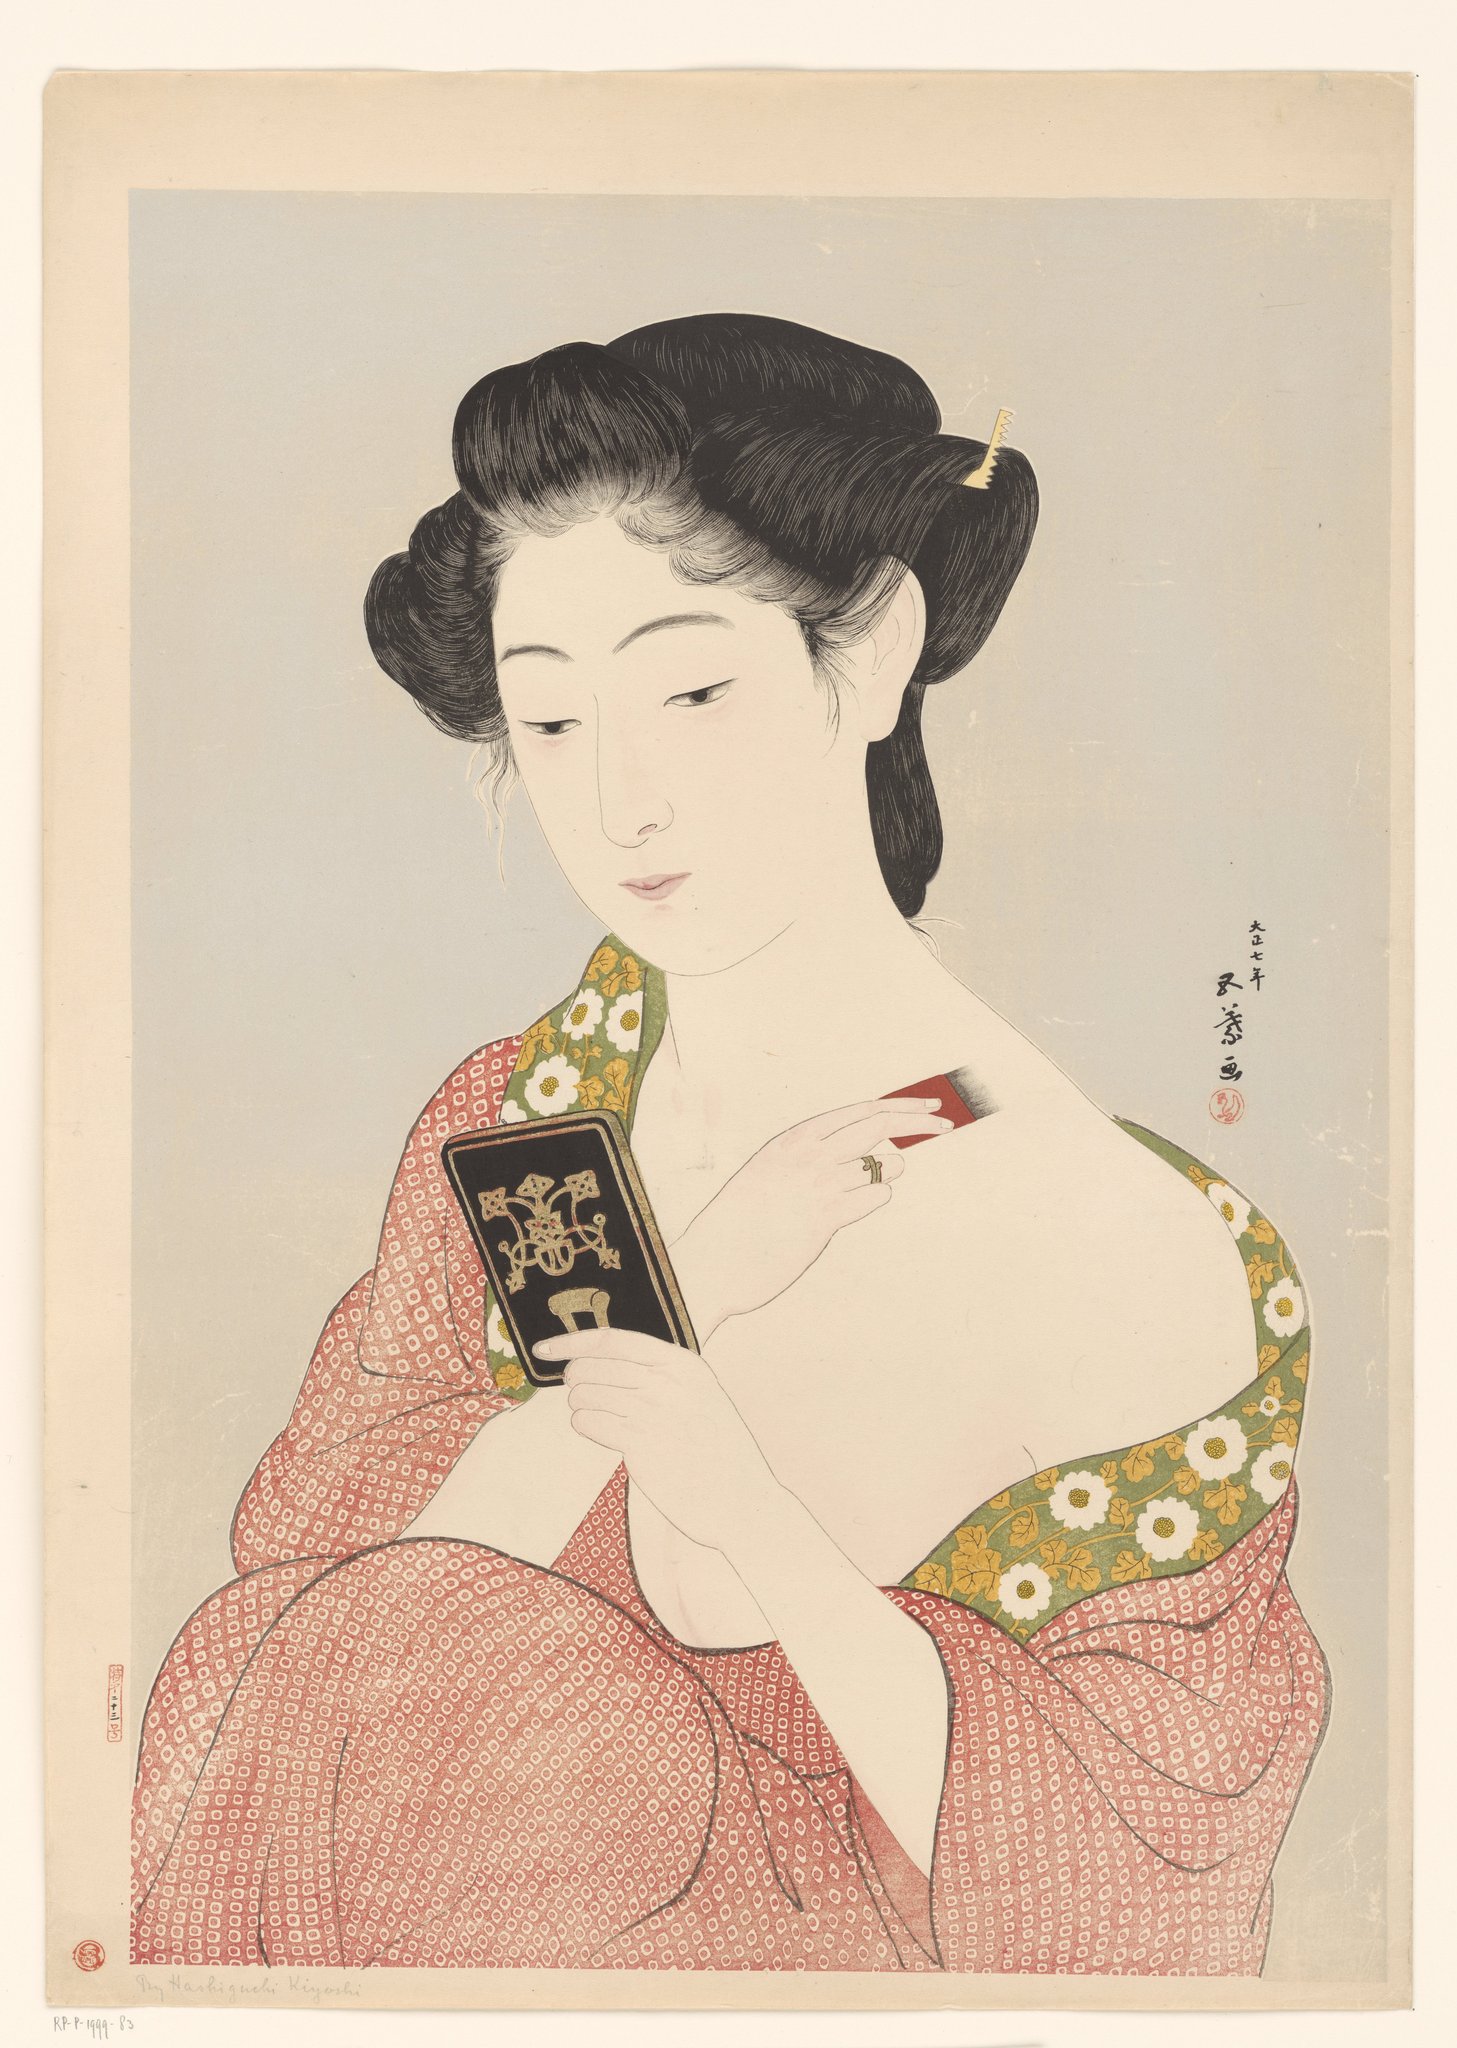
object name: print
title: Make-up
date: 1918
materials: paper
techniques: woodcut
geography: japan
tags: making up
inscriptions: collector's mark: Lugt 2228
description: Vrouw met half ontbloot bovenlijf en zwart lakspiegeltje in linker hand, zichzelf wit schminkend.